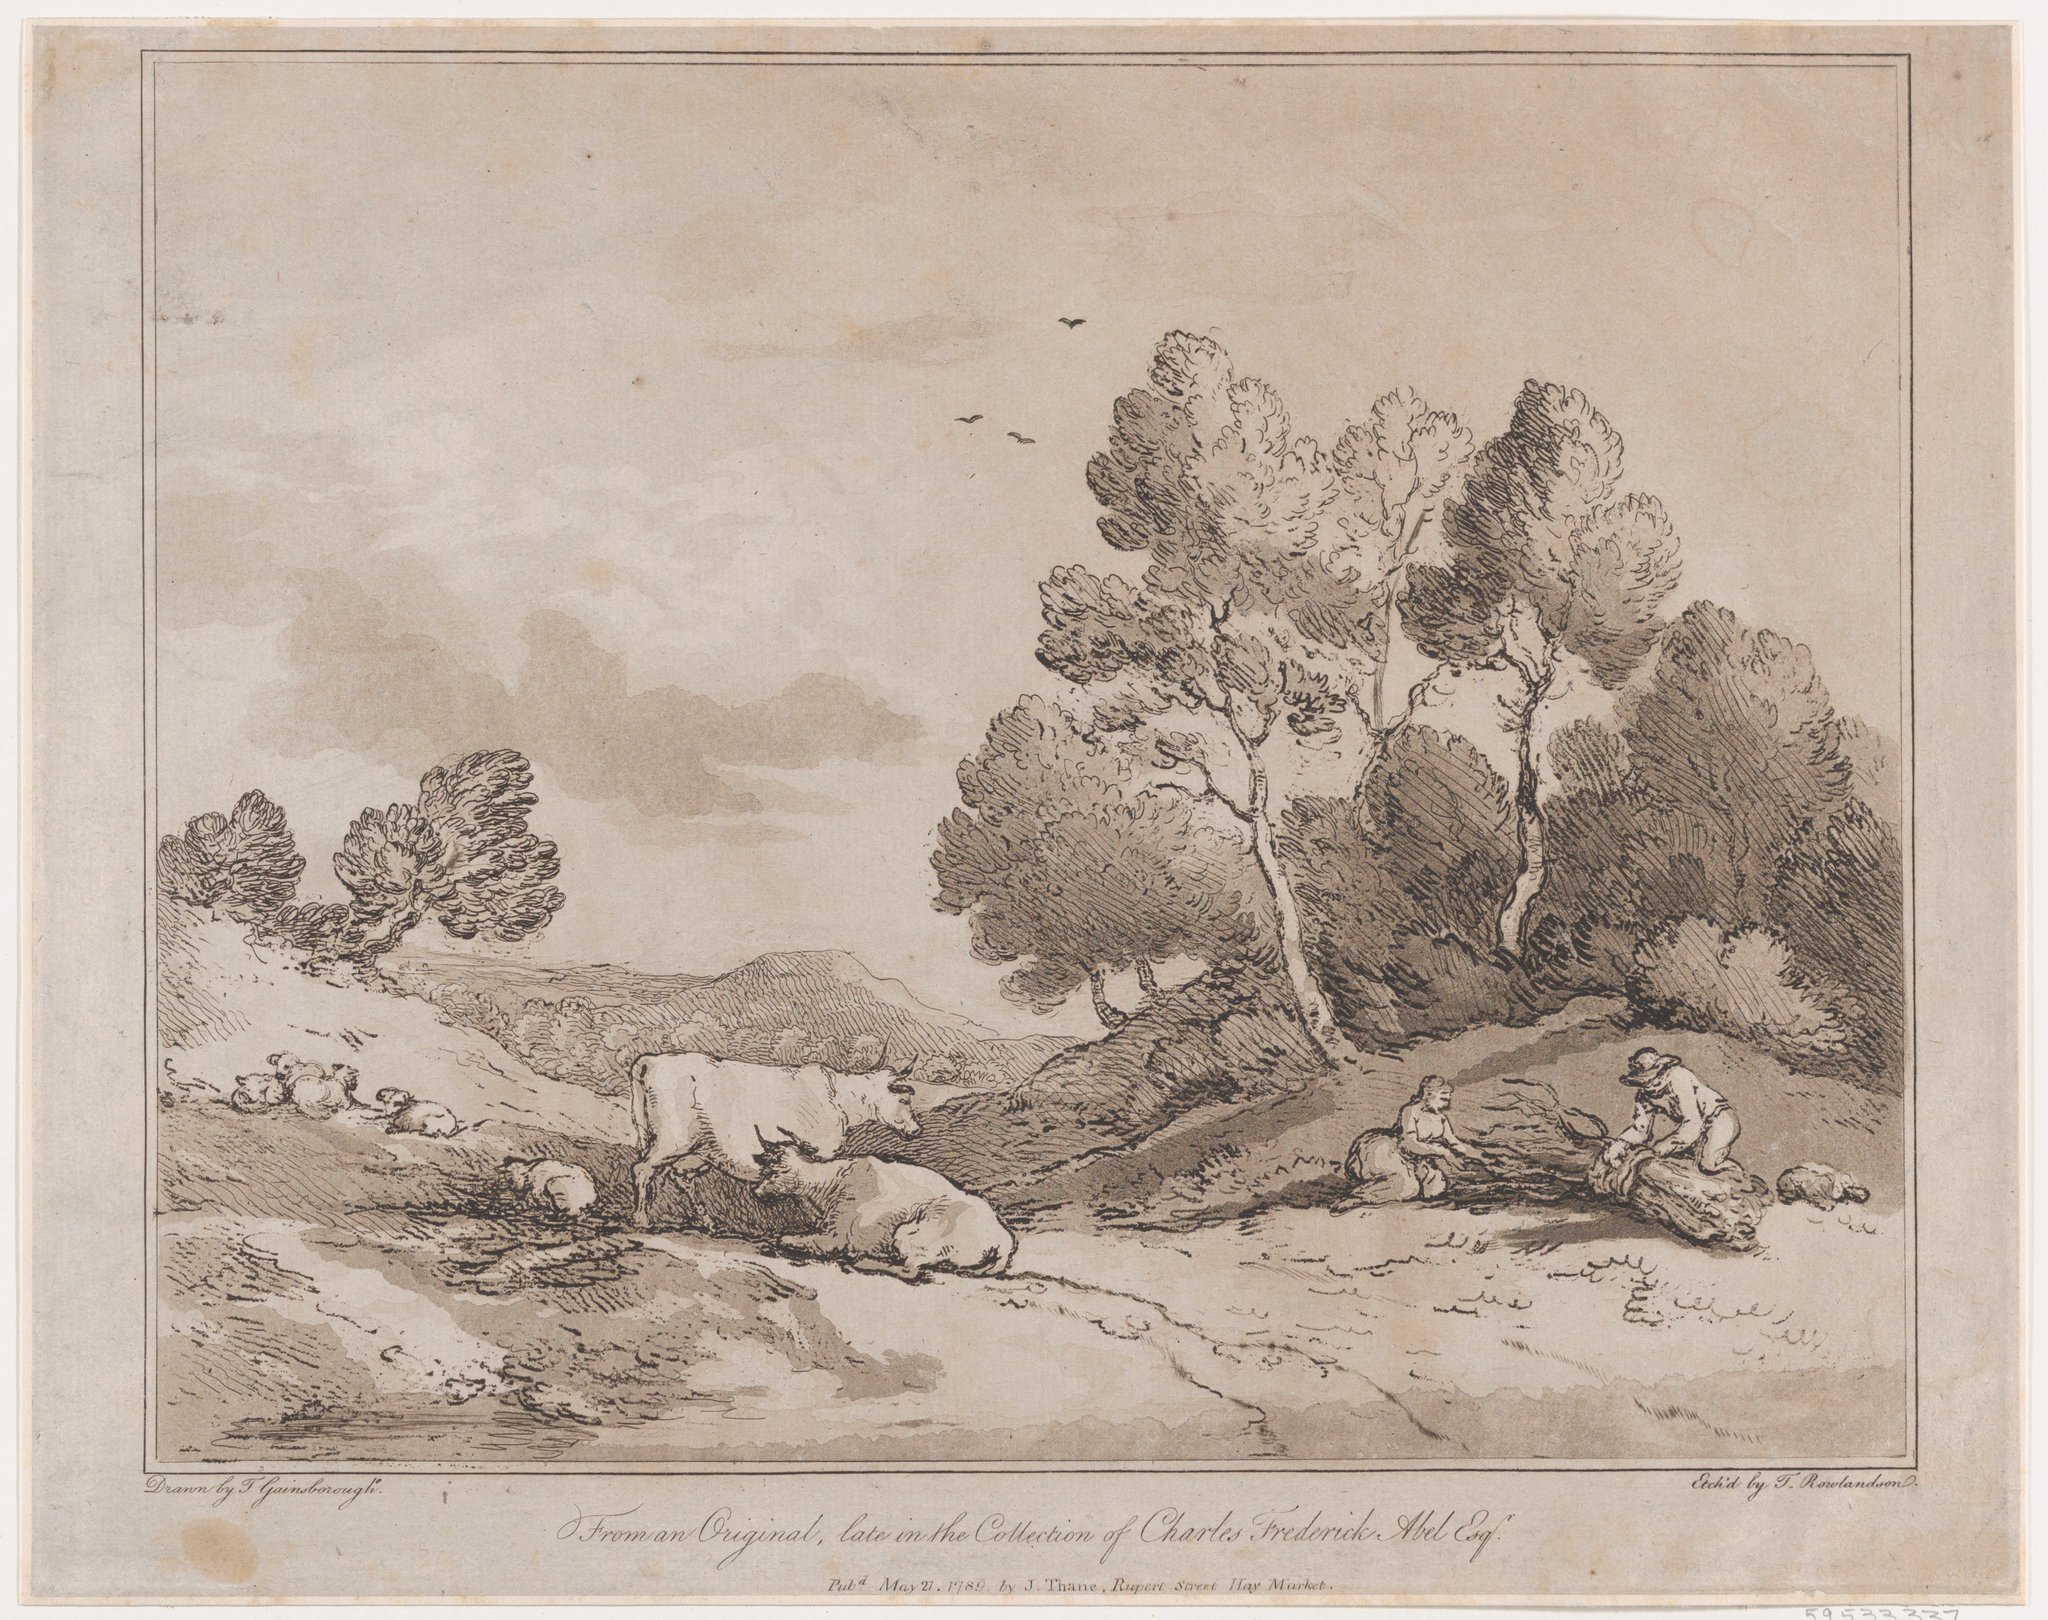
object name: print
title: Landscape with Figures Binding a Bundle of Wood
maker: thomas rowlandson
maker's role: artist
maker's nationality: british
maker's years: 1757-1827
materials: ink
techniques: aquatint, etching, printing